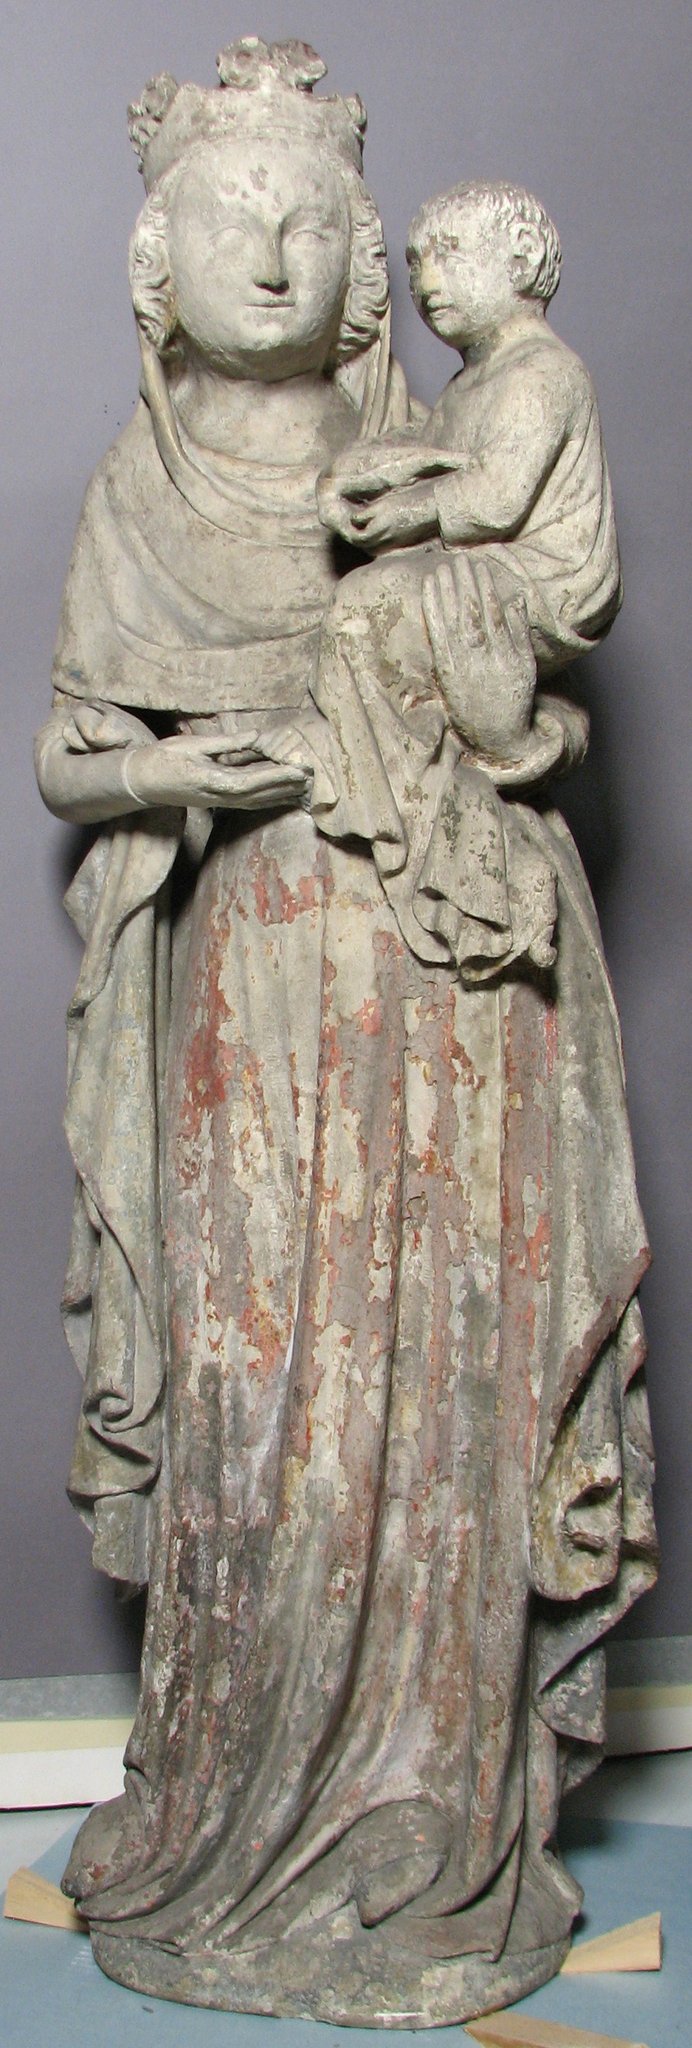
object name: statue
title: Standing Virgin and Child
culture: french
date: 1301-1400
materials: stone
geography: france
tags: madonna and child